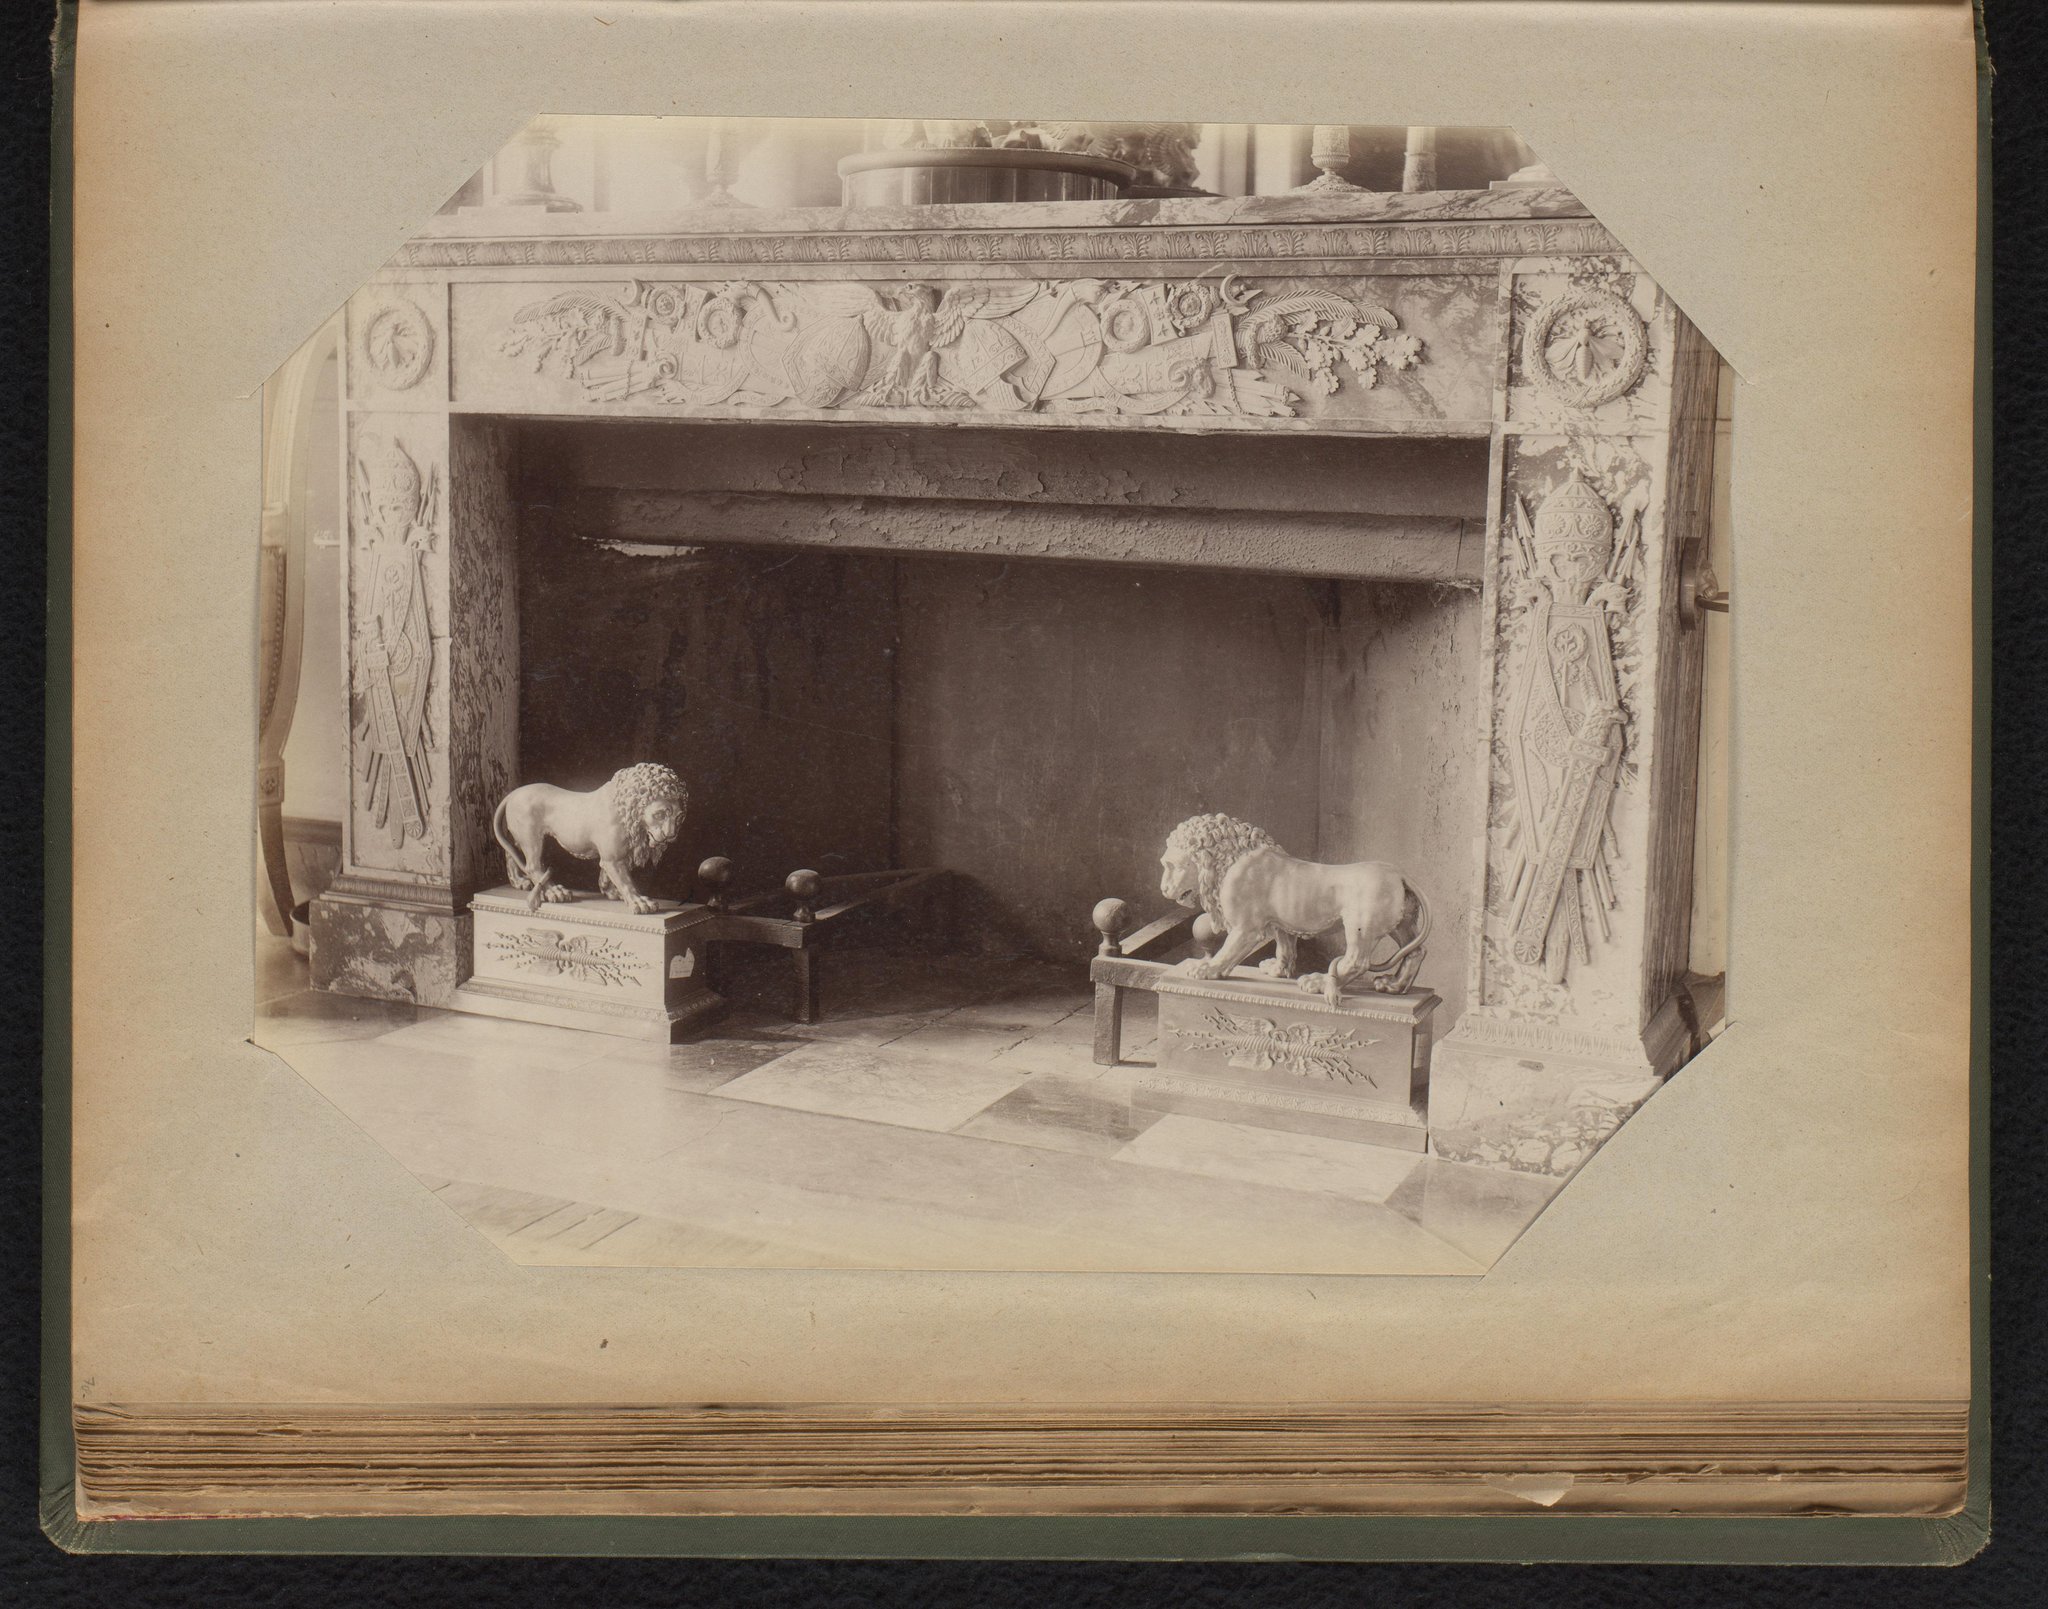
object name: photograph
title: Marmeren schouw gedecoreerd met familiewapens en onder twee beelden van leeuwen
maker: Anonymous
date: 1860-1900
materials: paper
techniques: albumen print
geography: france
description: Onderdeel van een serie met betrekking tot het interieur van het paleis van Versailles met kroonluchters, deuren, portalen en meubelstukken.